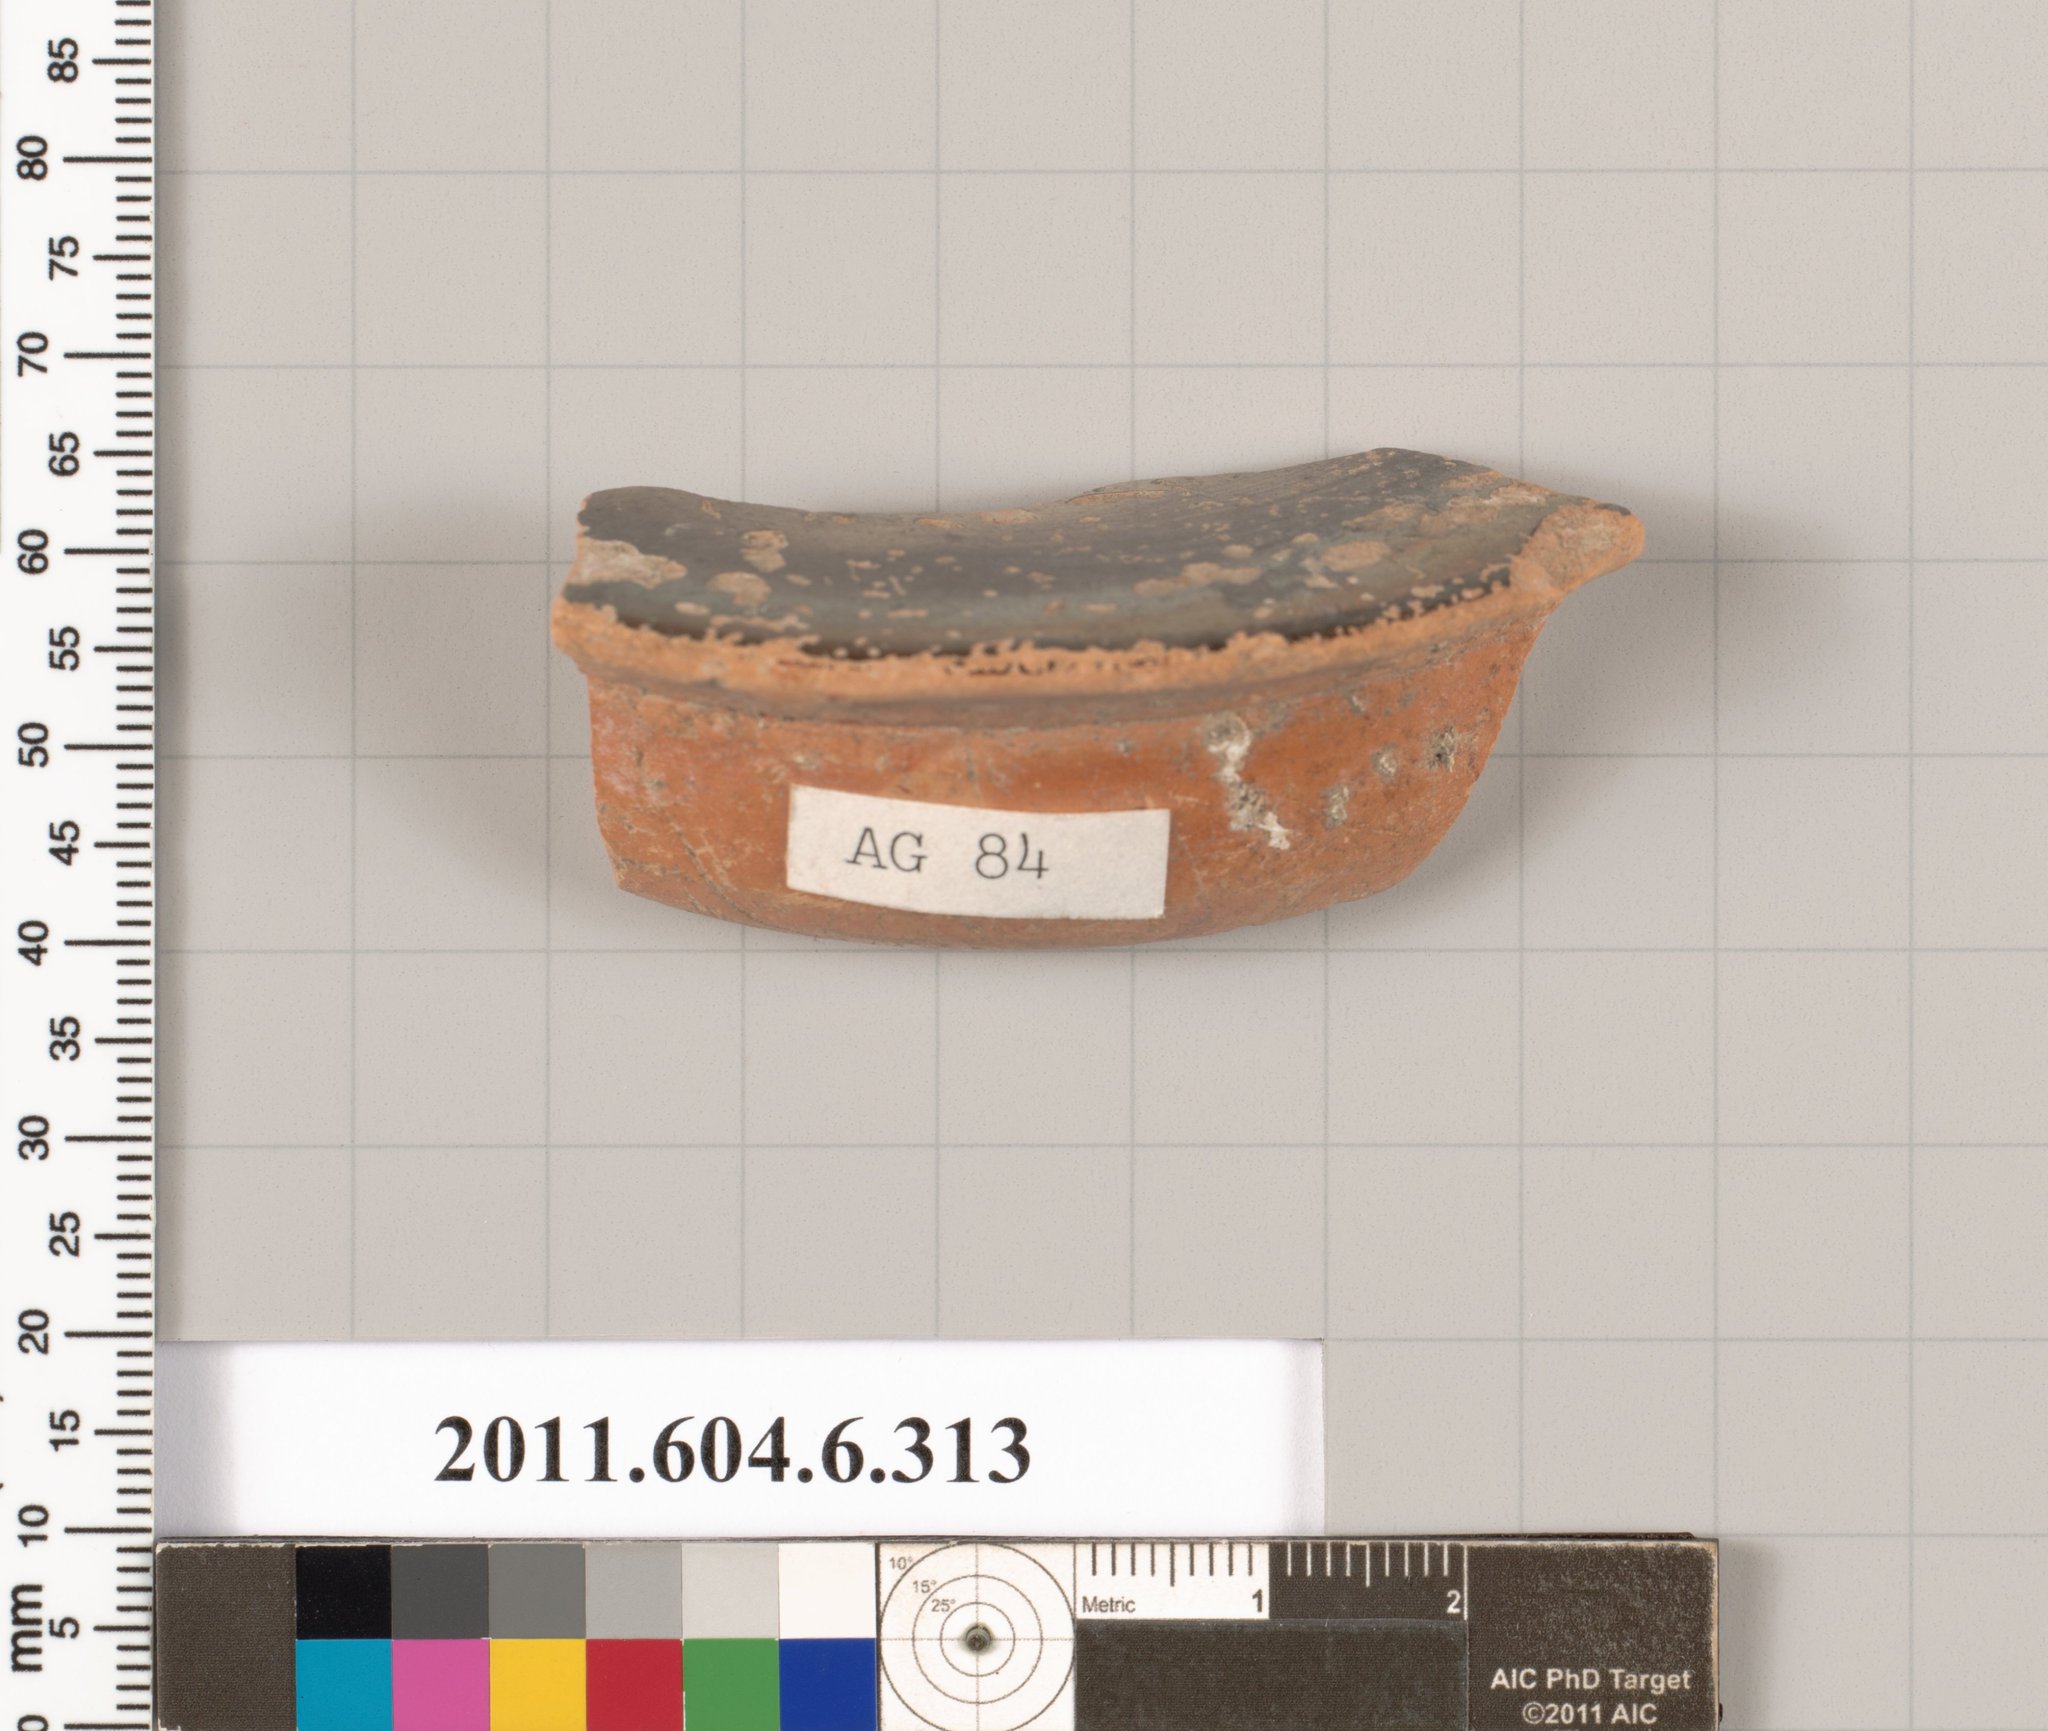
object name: lamp fragment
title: Terracotta fragment of a lamp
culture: greek, attic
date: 525-480 BCE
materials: terracotta